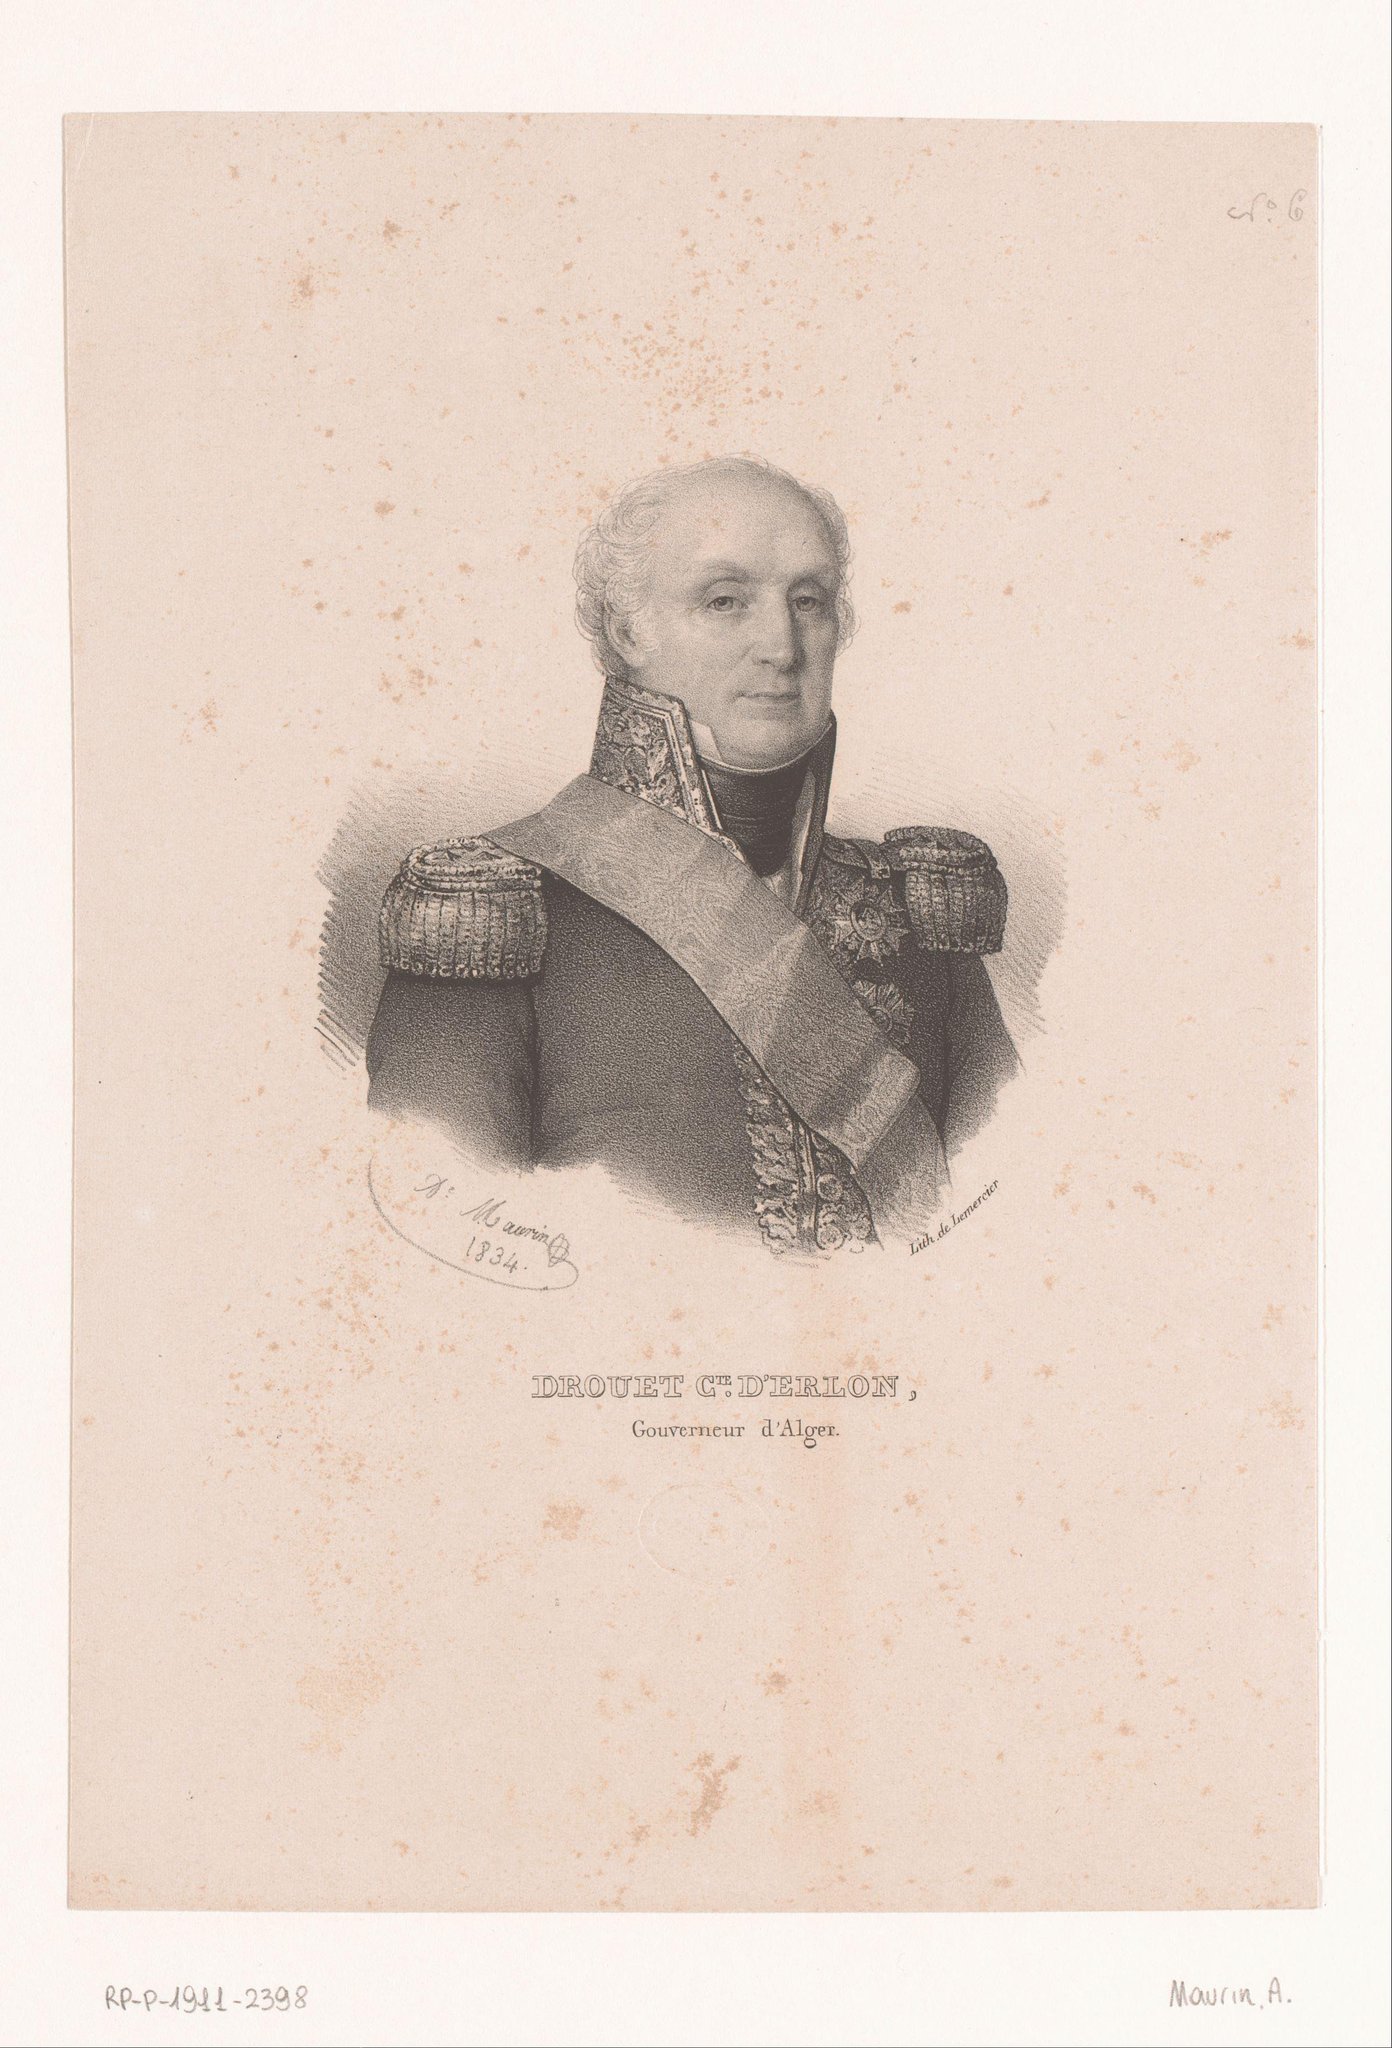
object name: print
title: Drouet Cte. d'Erlon, gouverneur d'Alger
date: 1834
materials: paper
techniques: lithograph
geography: paris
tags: paris, commander-in-chief, general, marshal, historical persons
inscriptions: check stamp: Lugt 4733, collector's mark: Lugt 2228